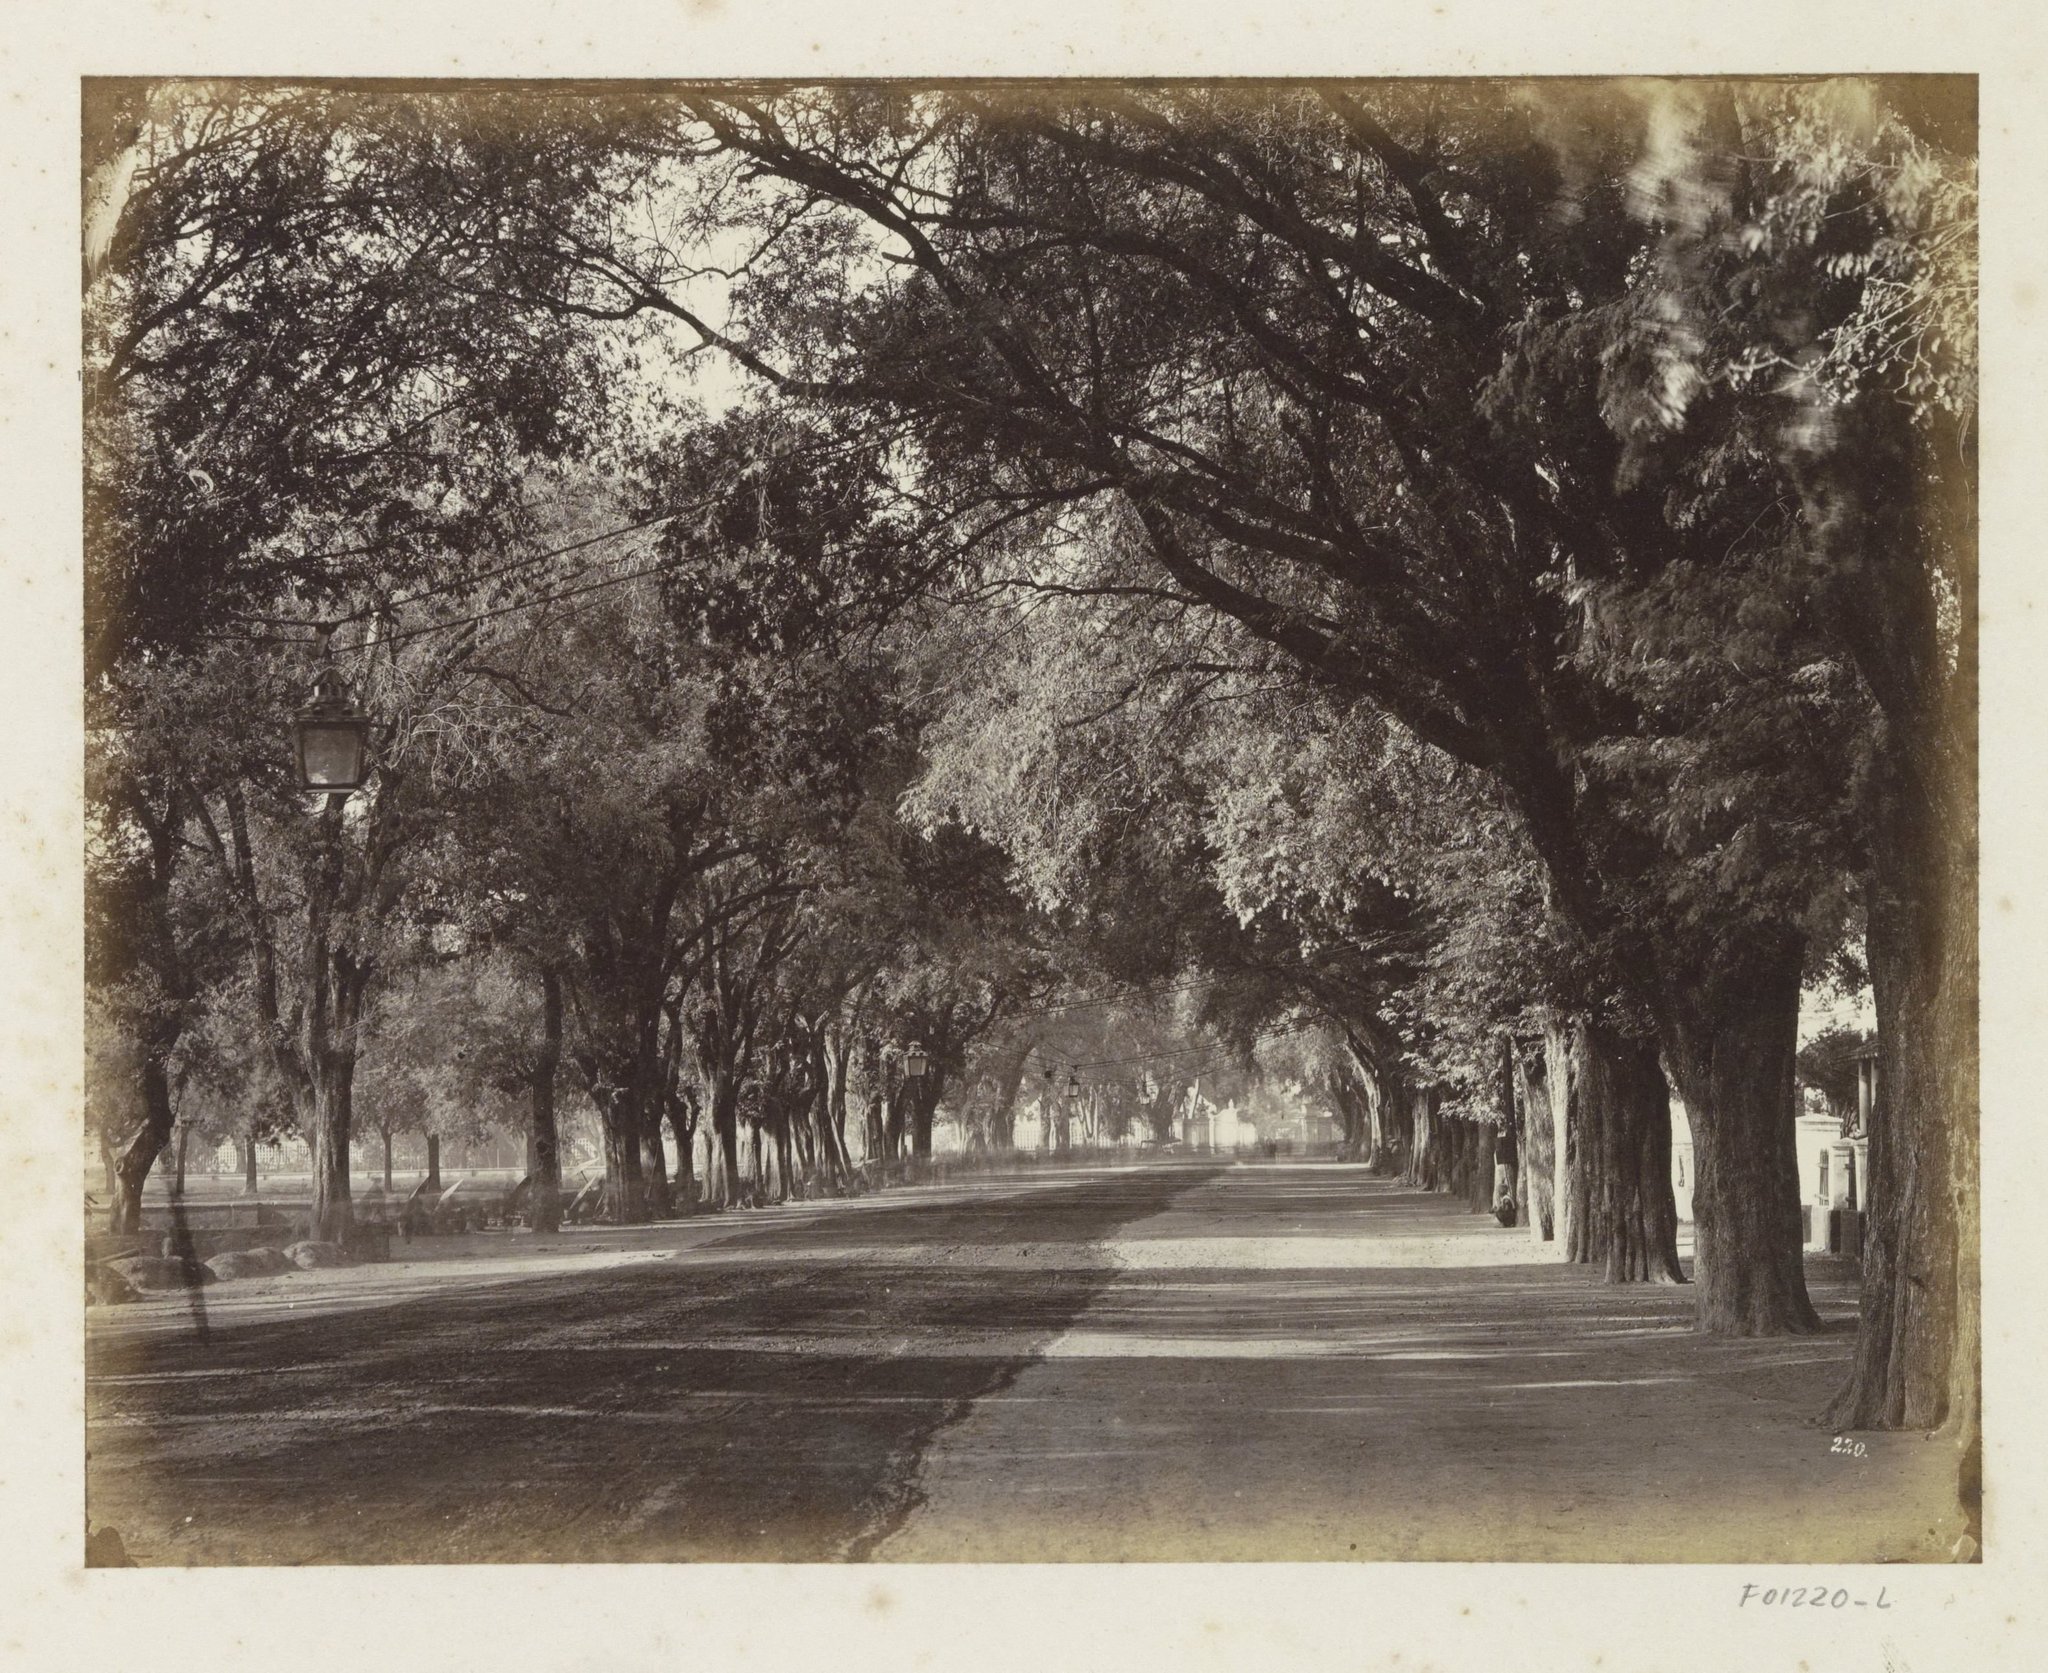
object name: photograph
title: Brede laan op Java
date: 1857-1870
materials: photographic support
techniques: albumen print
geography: java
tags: forest path or lane, java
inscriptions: number: ‘220’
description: Onderdeel van Fotoalbum met opnames van bezienswaardigheden op Java.